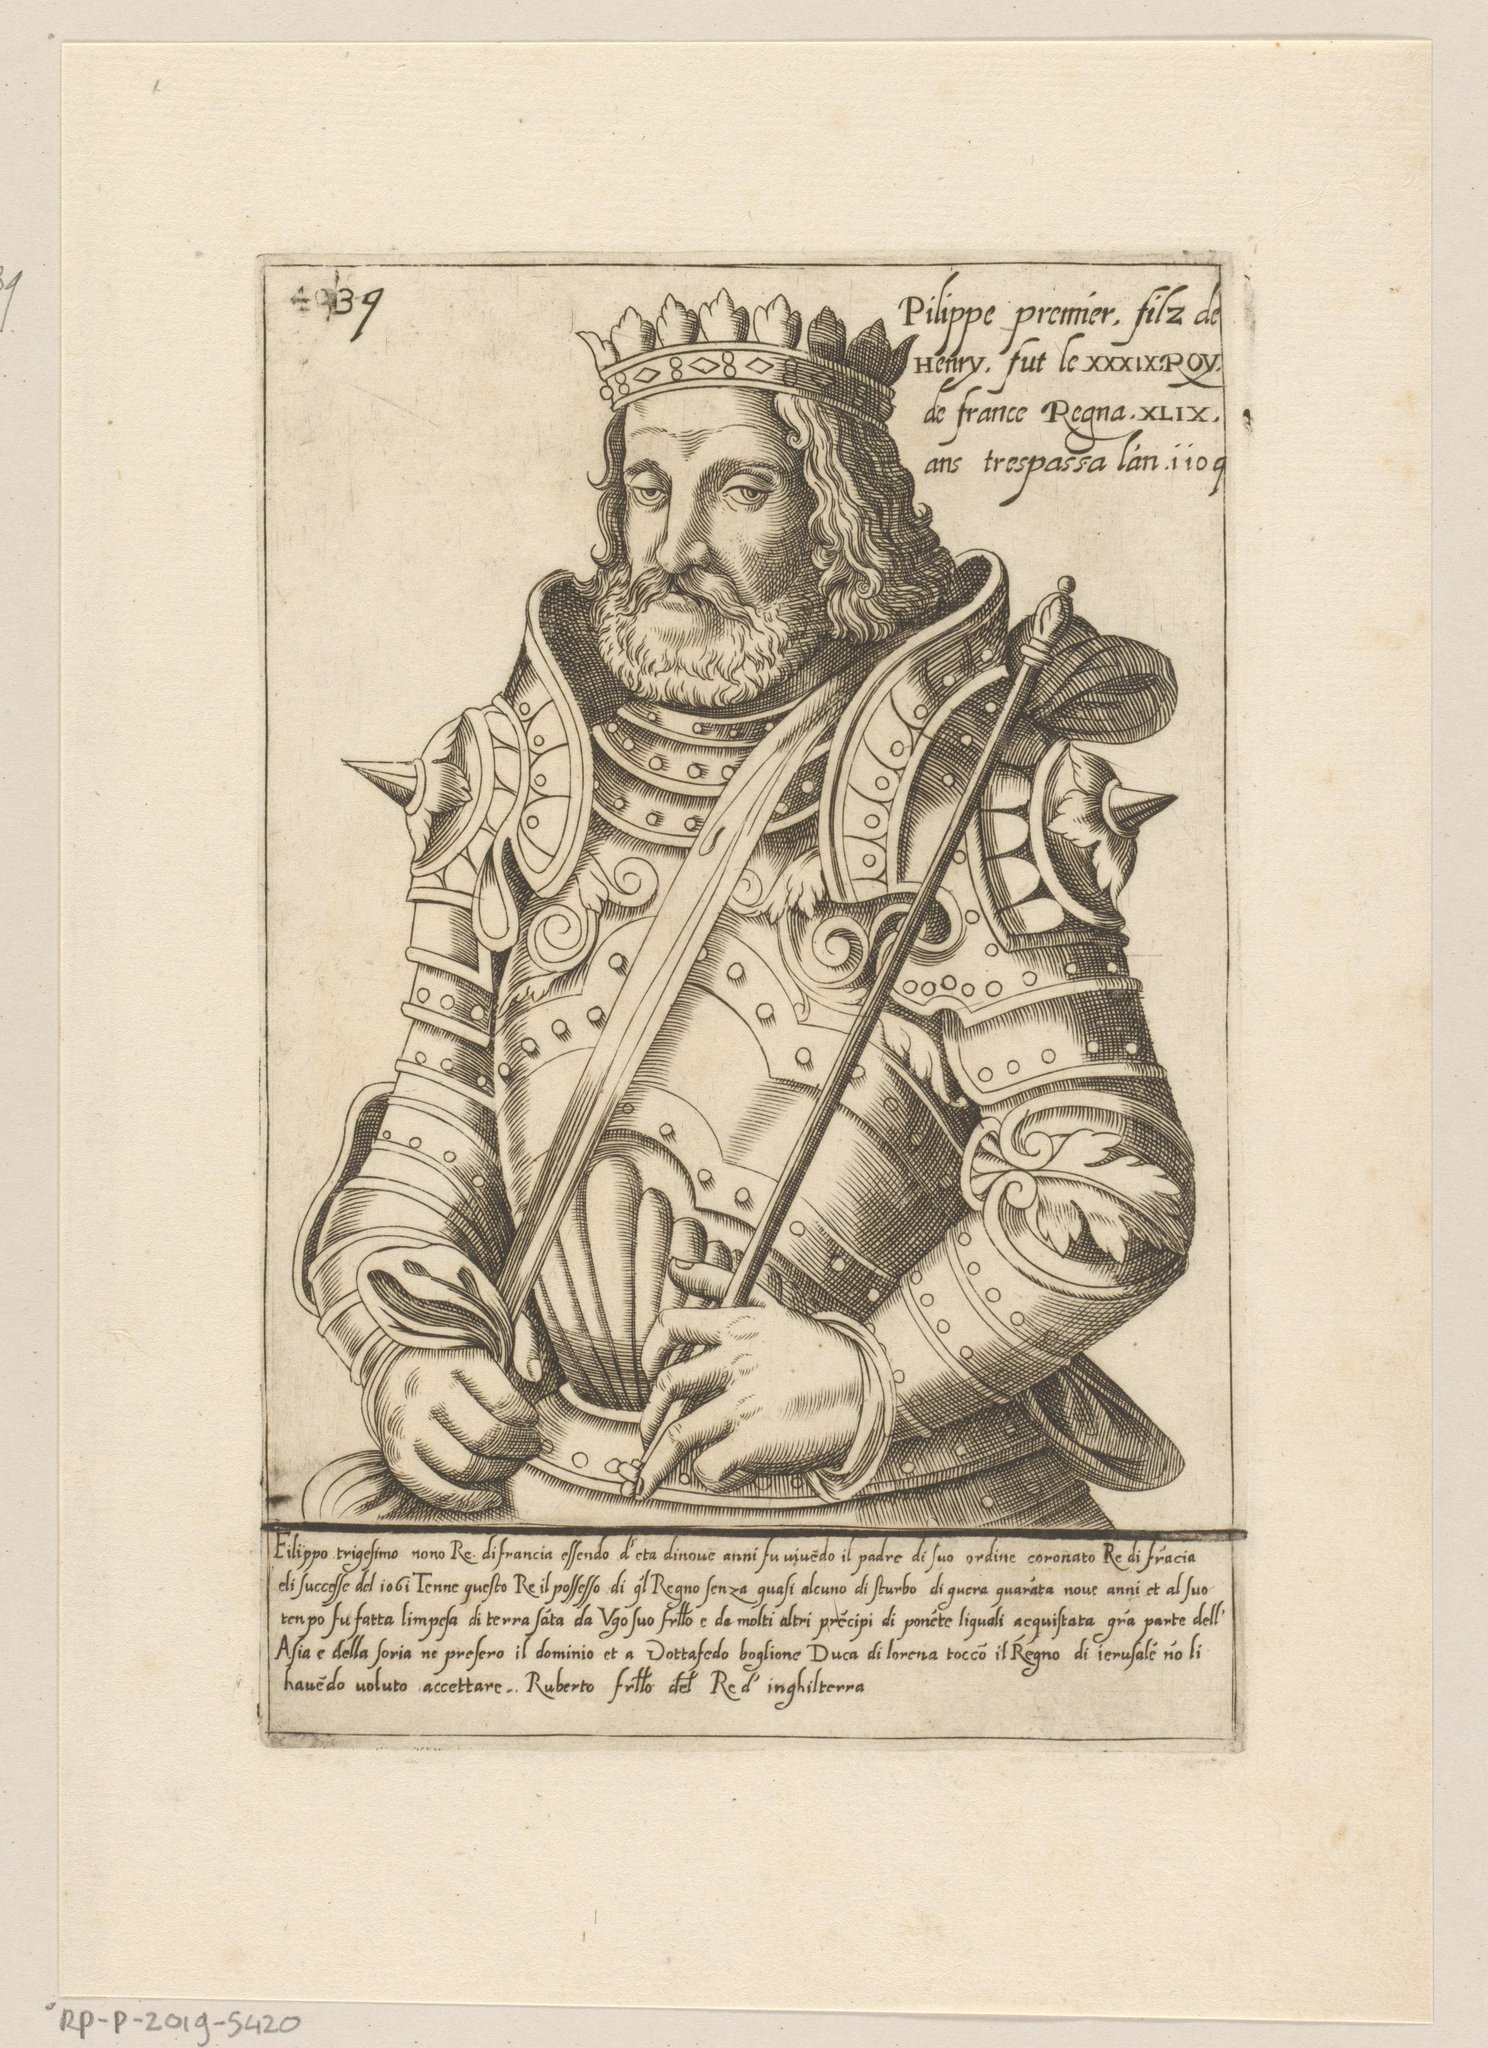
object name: print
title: Portret van Filips I, koning van Frankrijk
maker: Anonymous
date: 1588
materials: paper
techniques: engraving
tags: crown (symbol of sovereignty), sceptre, staff (symbol of sovereignty), historical persons, king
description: Prent voor het eerst gebruikt in: Cronica Breve de i fatti illustri de're di Francia, con le loro effigie dal naturale cominciando da Faramondo (...). Venetië: Bernardo Giunti, 1588. Prent in ieder geval ook gebruikt in de editie van 1590 en mogelijk ook in een Franse uitgave van 1597.